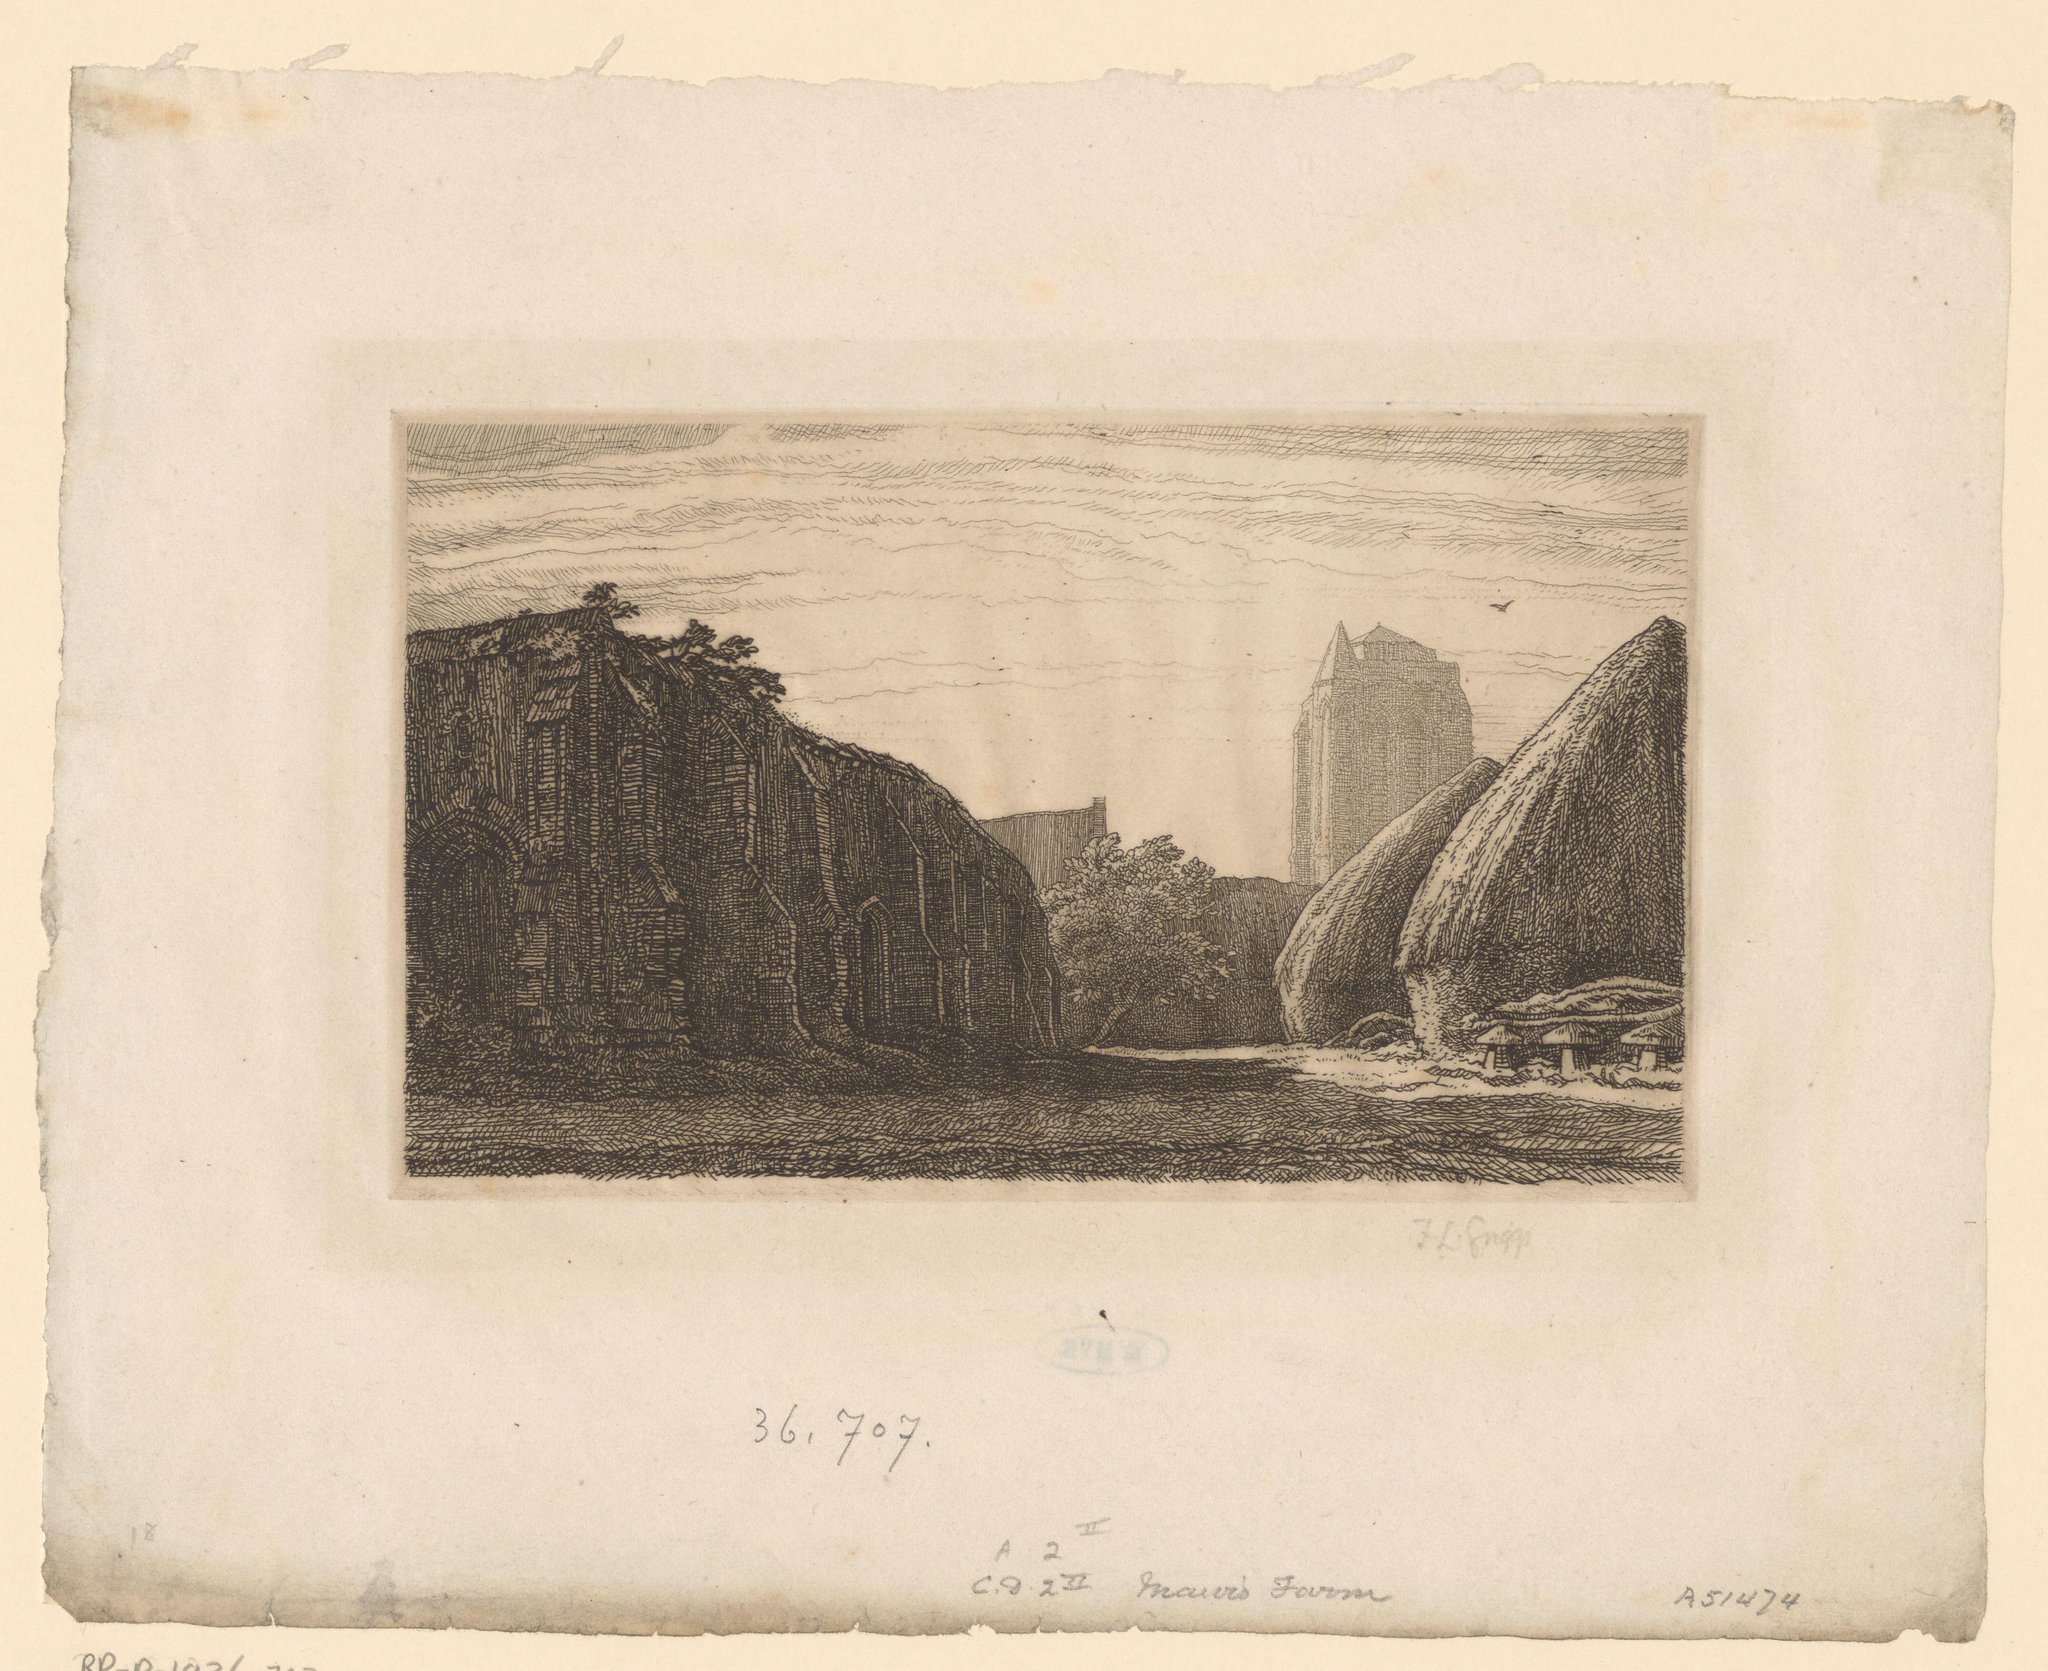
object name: print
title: Twee hutten naast een ruïne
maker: frederick landseer maur griggs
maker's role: print maker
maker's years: 1876-1938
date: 1913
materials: paper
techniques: etching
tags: ruin of church, monastery, etc., farm (building), parts of church exterior and annexes: tower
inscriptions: signature: ‘F.L. Griggs’, collector's mark: Lugt 2228